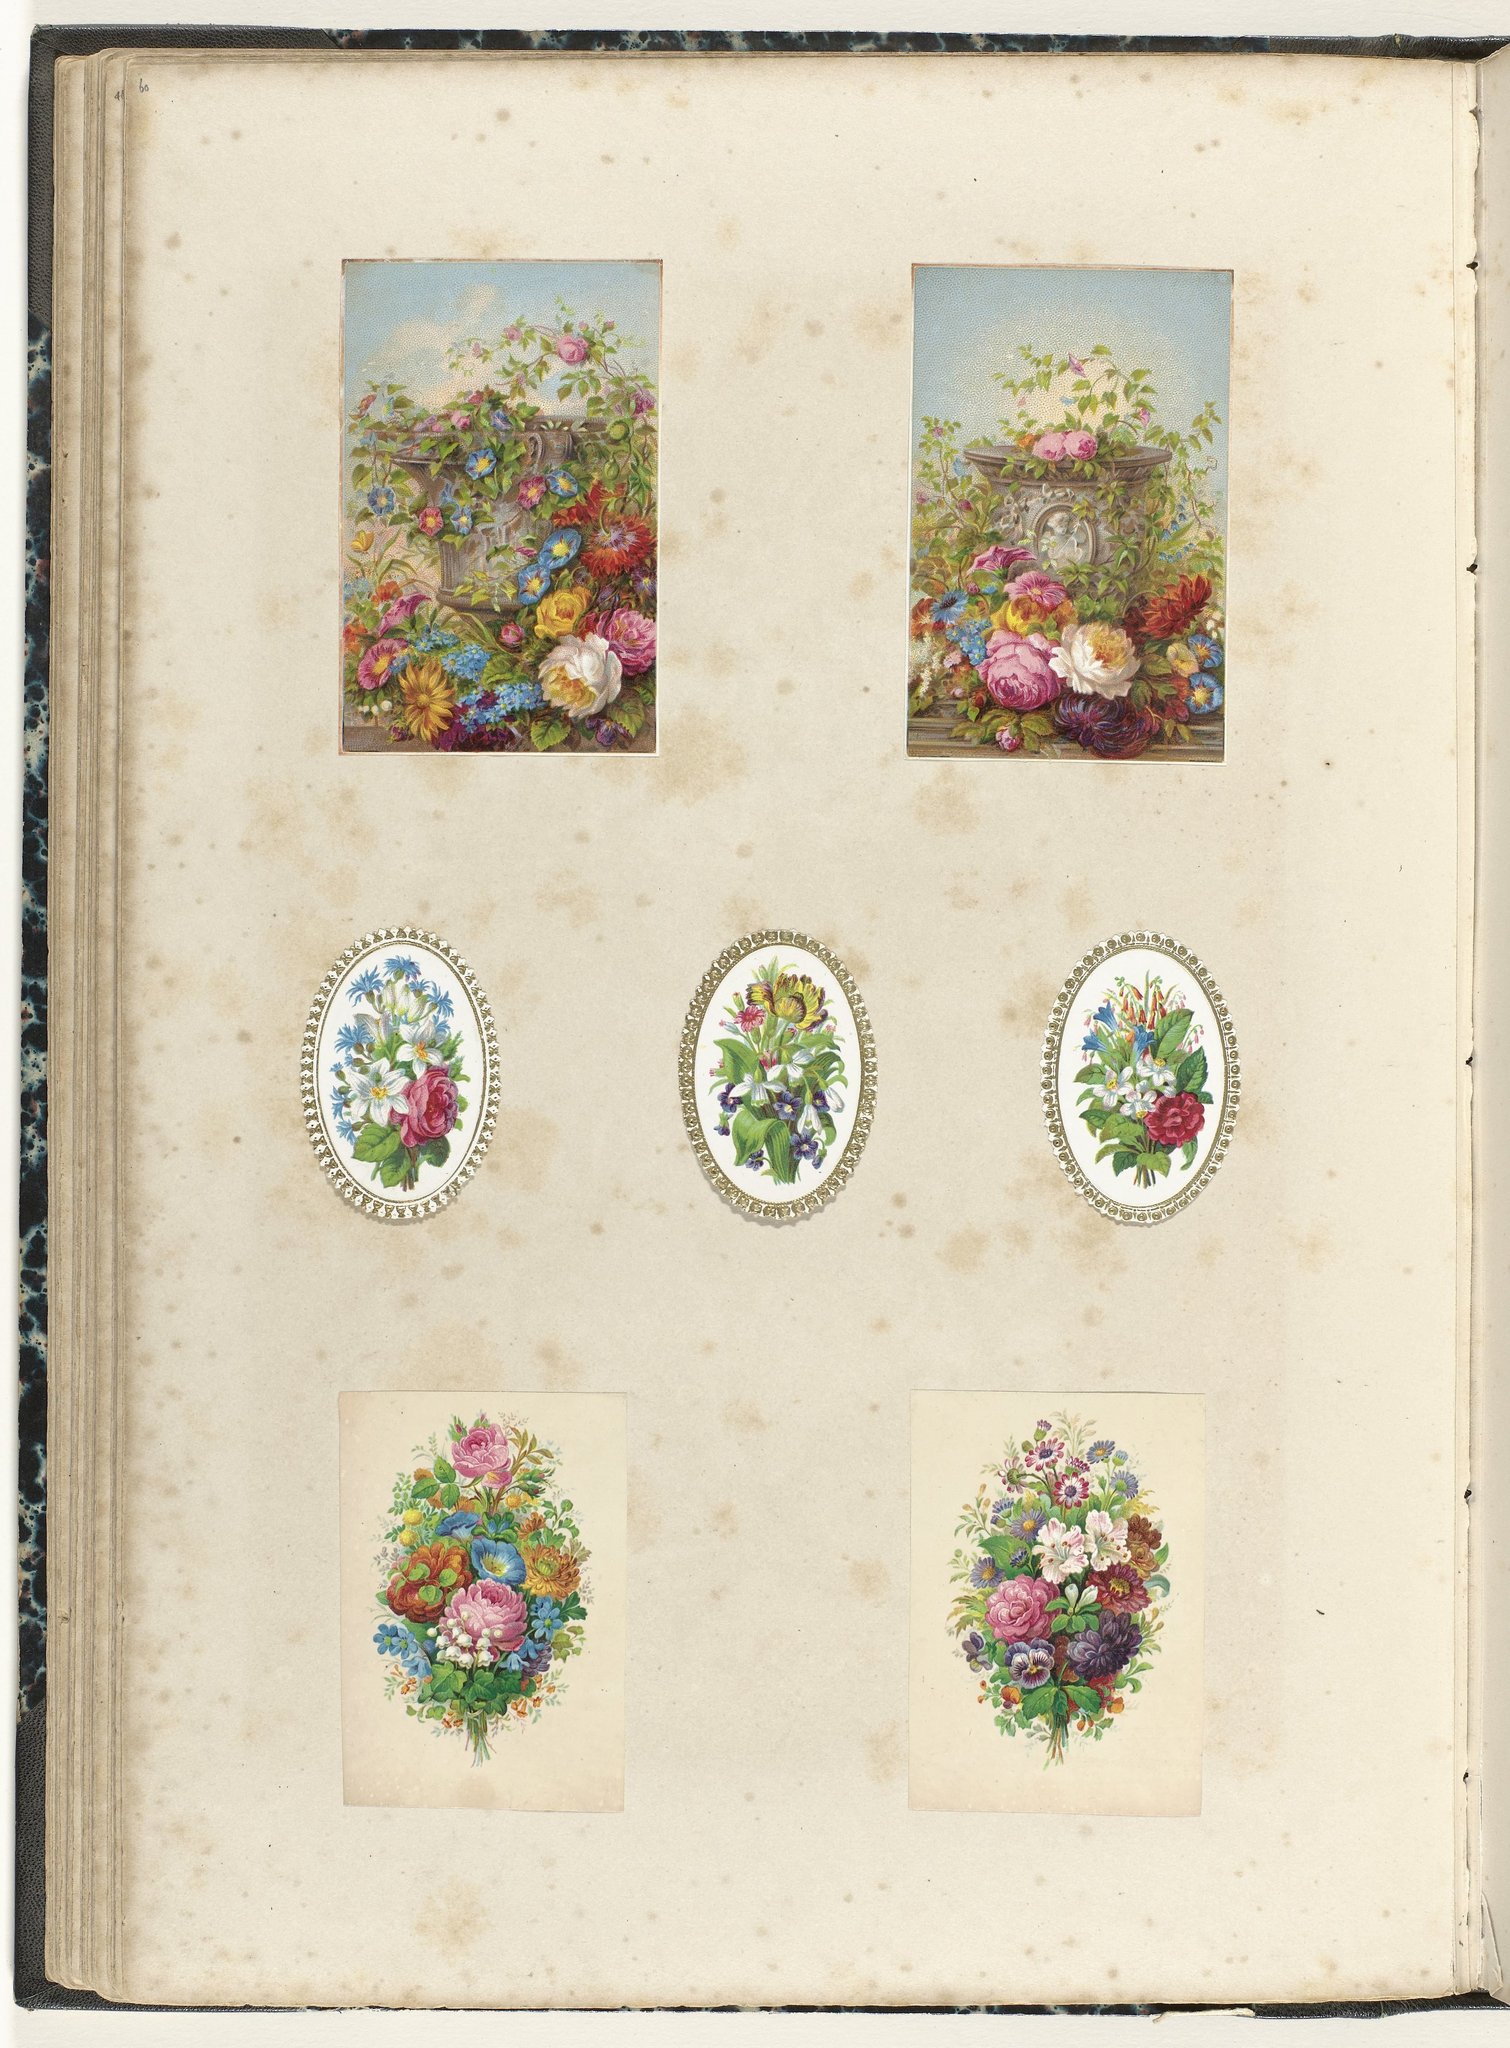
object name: poëzieplaatje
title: Zeven poëzieplaatjes met bloemen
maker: Anonymous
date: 1866-1900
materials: paper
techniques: mechanical printing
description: Bovenaan zijn twee rechthoekige plaatjes geplakt met vazen omringd door bloemen, in het midden bevinden zich drie ovale plaatjes met bloemen en onderaan twee rechthoekige plaatjes met boeketten van bloemen.